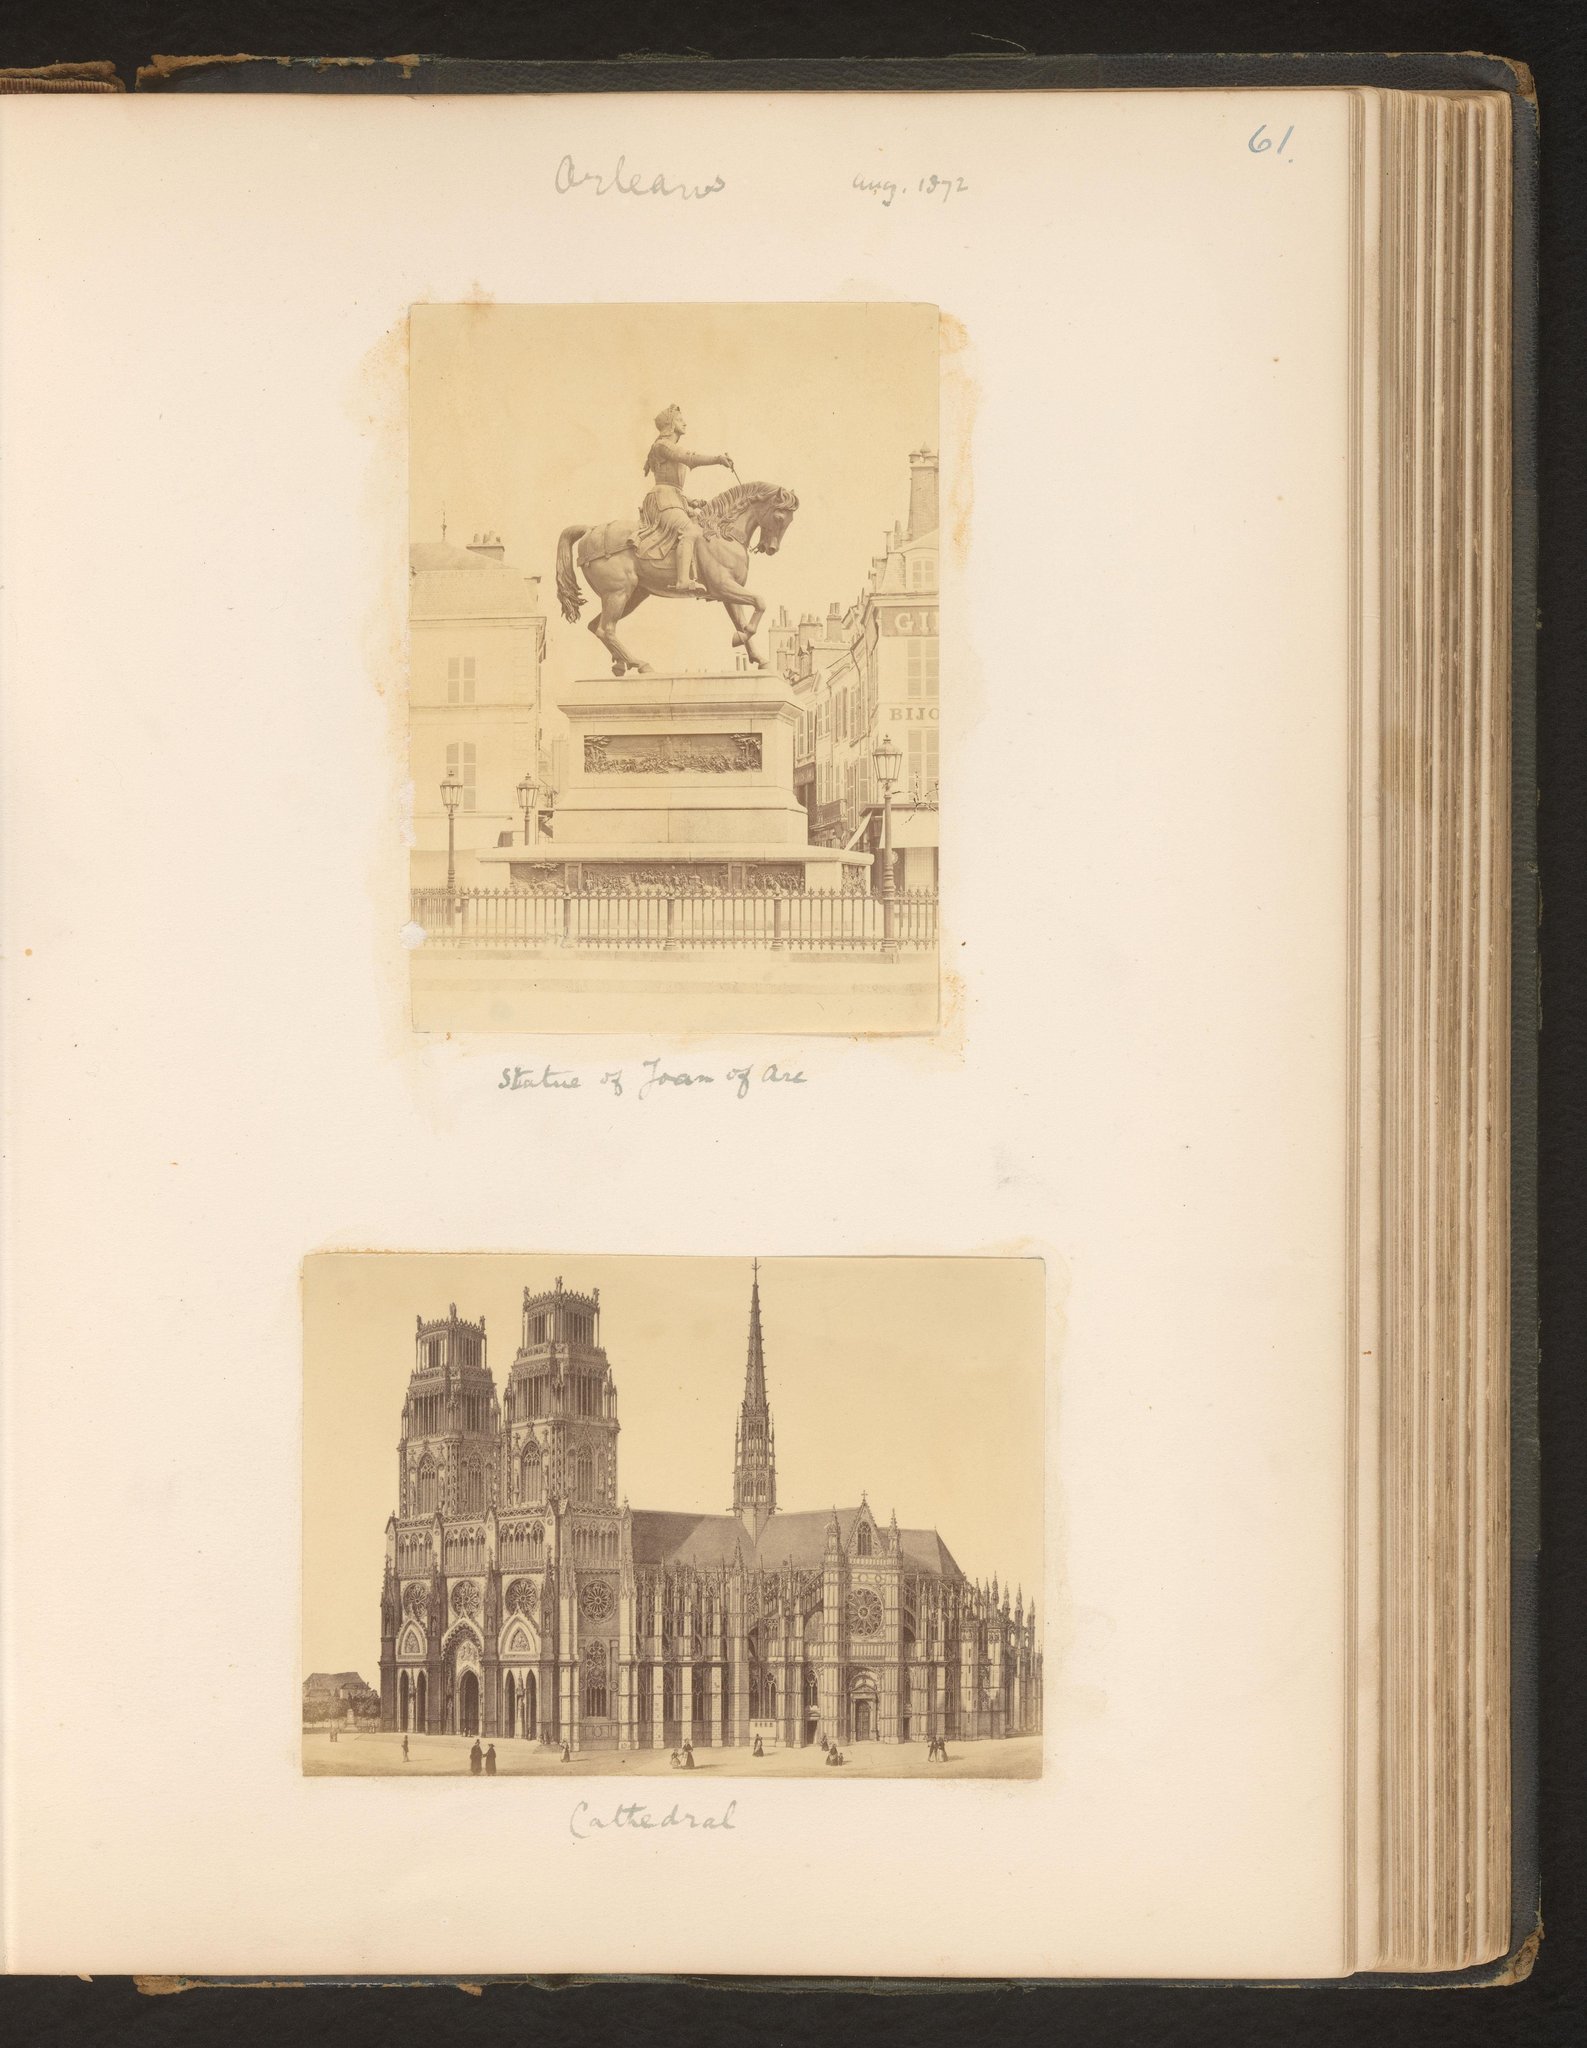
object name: photograph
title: Gezichten op Orléans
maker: Anonymous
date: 1808-1871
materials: paper, photographic support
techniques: albumen print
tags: church (exterior), monument, statue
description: Standbeeld van Jeanne d'Arc en een gezicht op de Kathedraal van Orléans. Deze pagina maakt deel uit van een album.